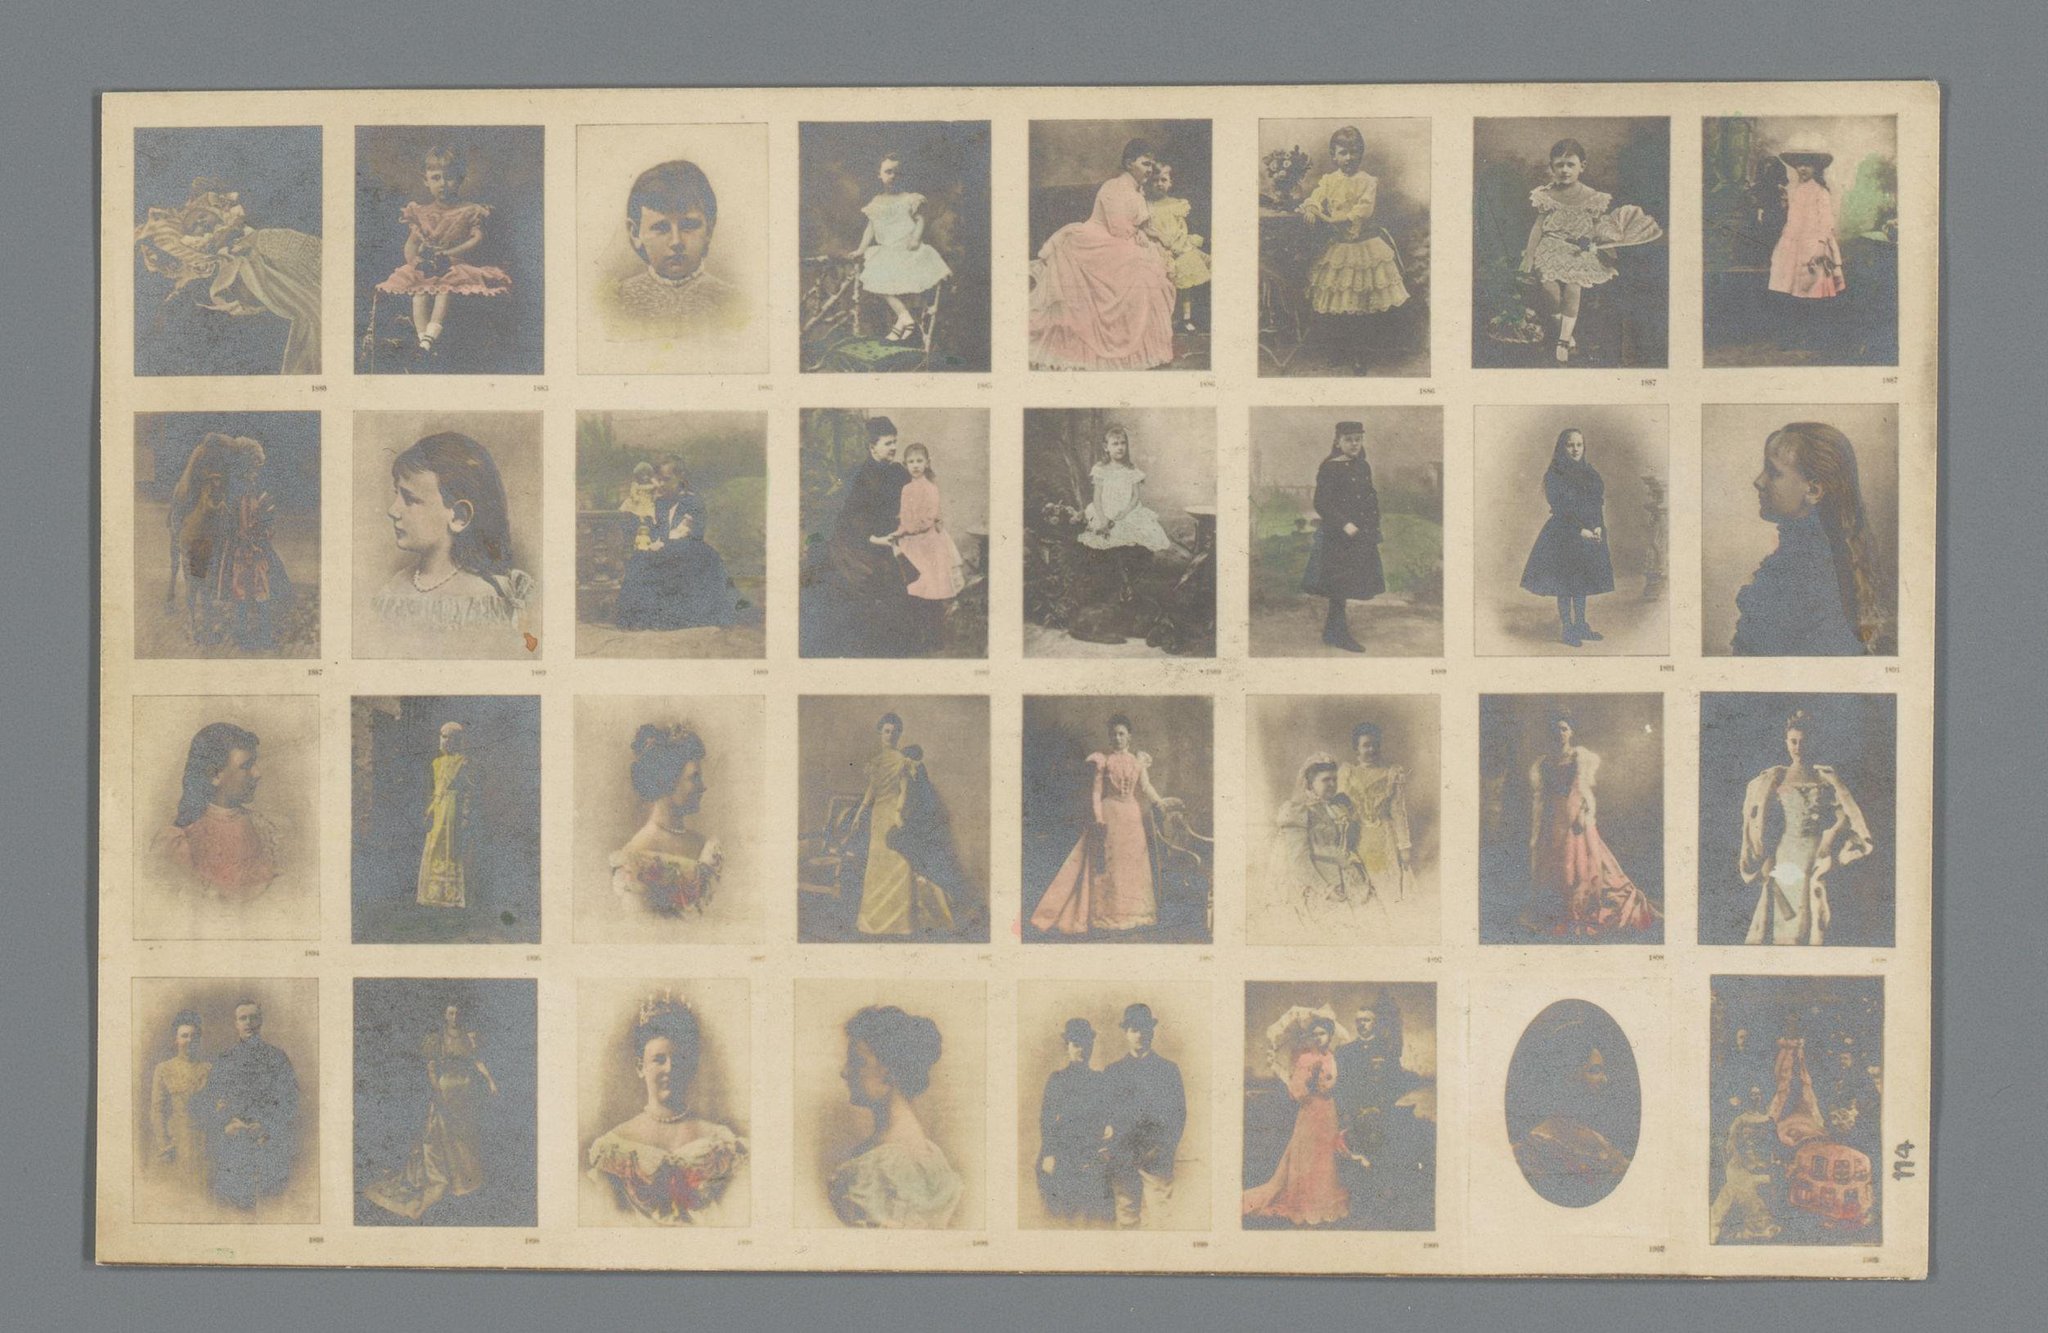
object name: ansichtkaart, prentbriefkaart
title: 32 foto's van Wilhelmina der Nederlanden in chronologische volgorde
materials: paper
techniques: gelatin silver print, hand coloring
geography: the hague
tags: print maker, wilhelmina of the netherlands, queen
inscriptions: number: ‘1288’